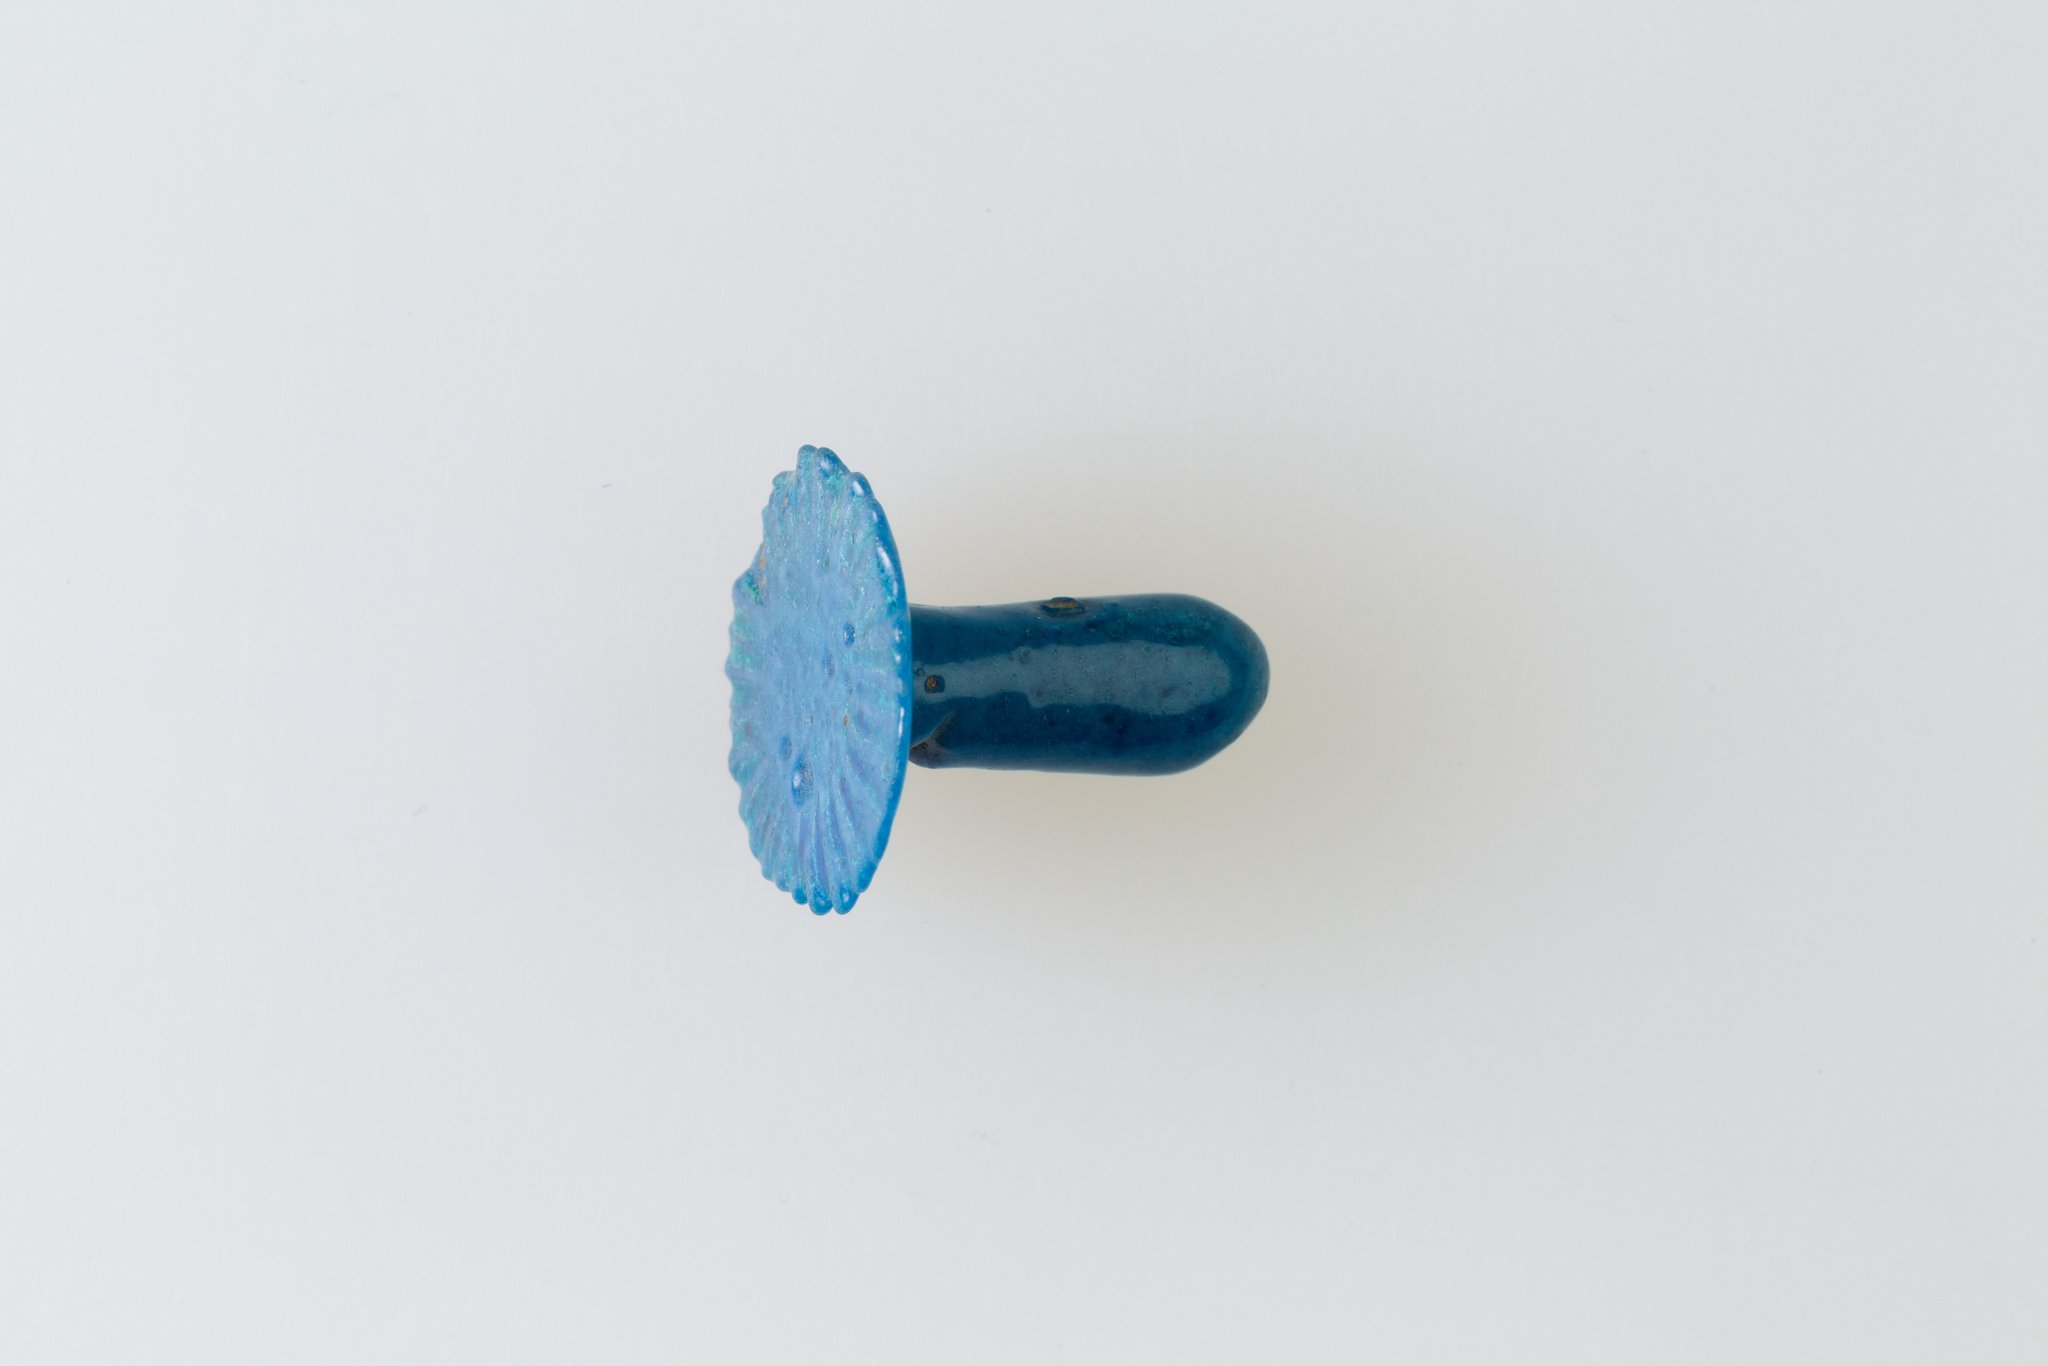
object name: ear stud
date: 1295-1070 BCE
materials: faience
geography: egypt